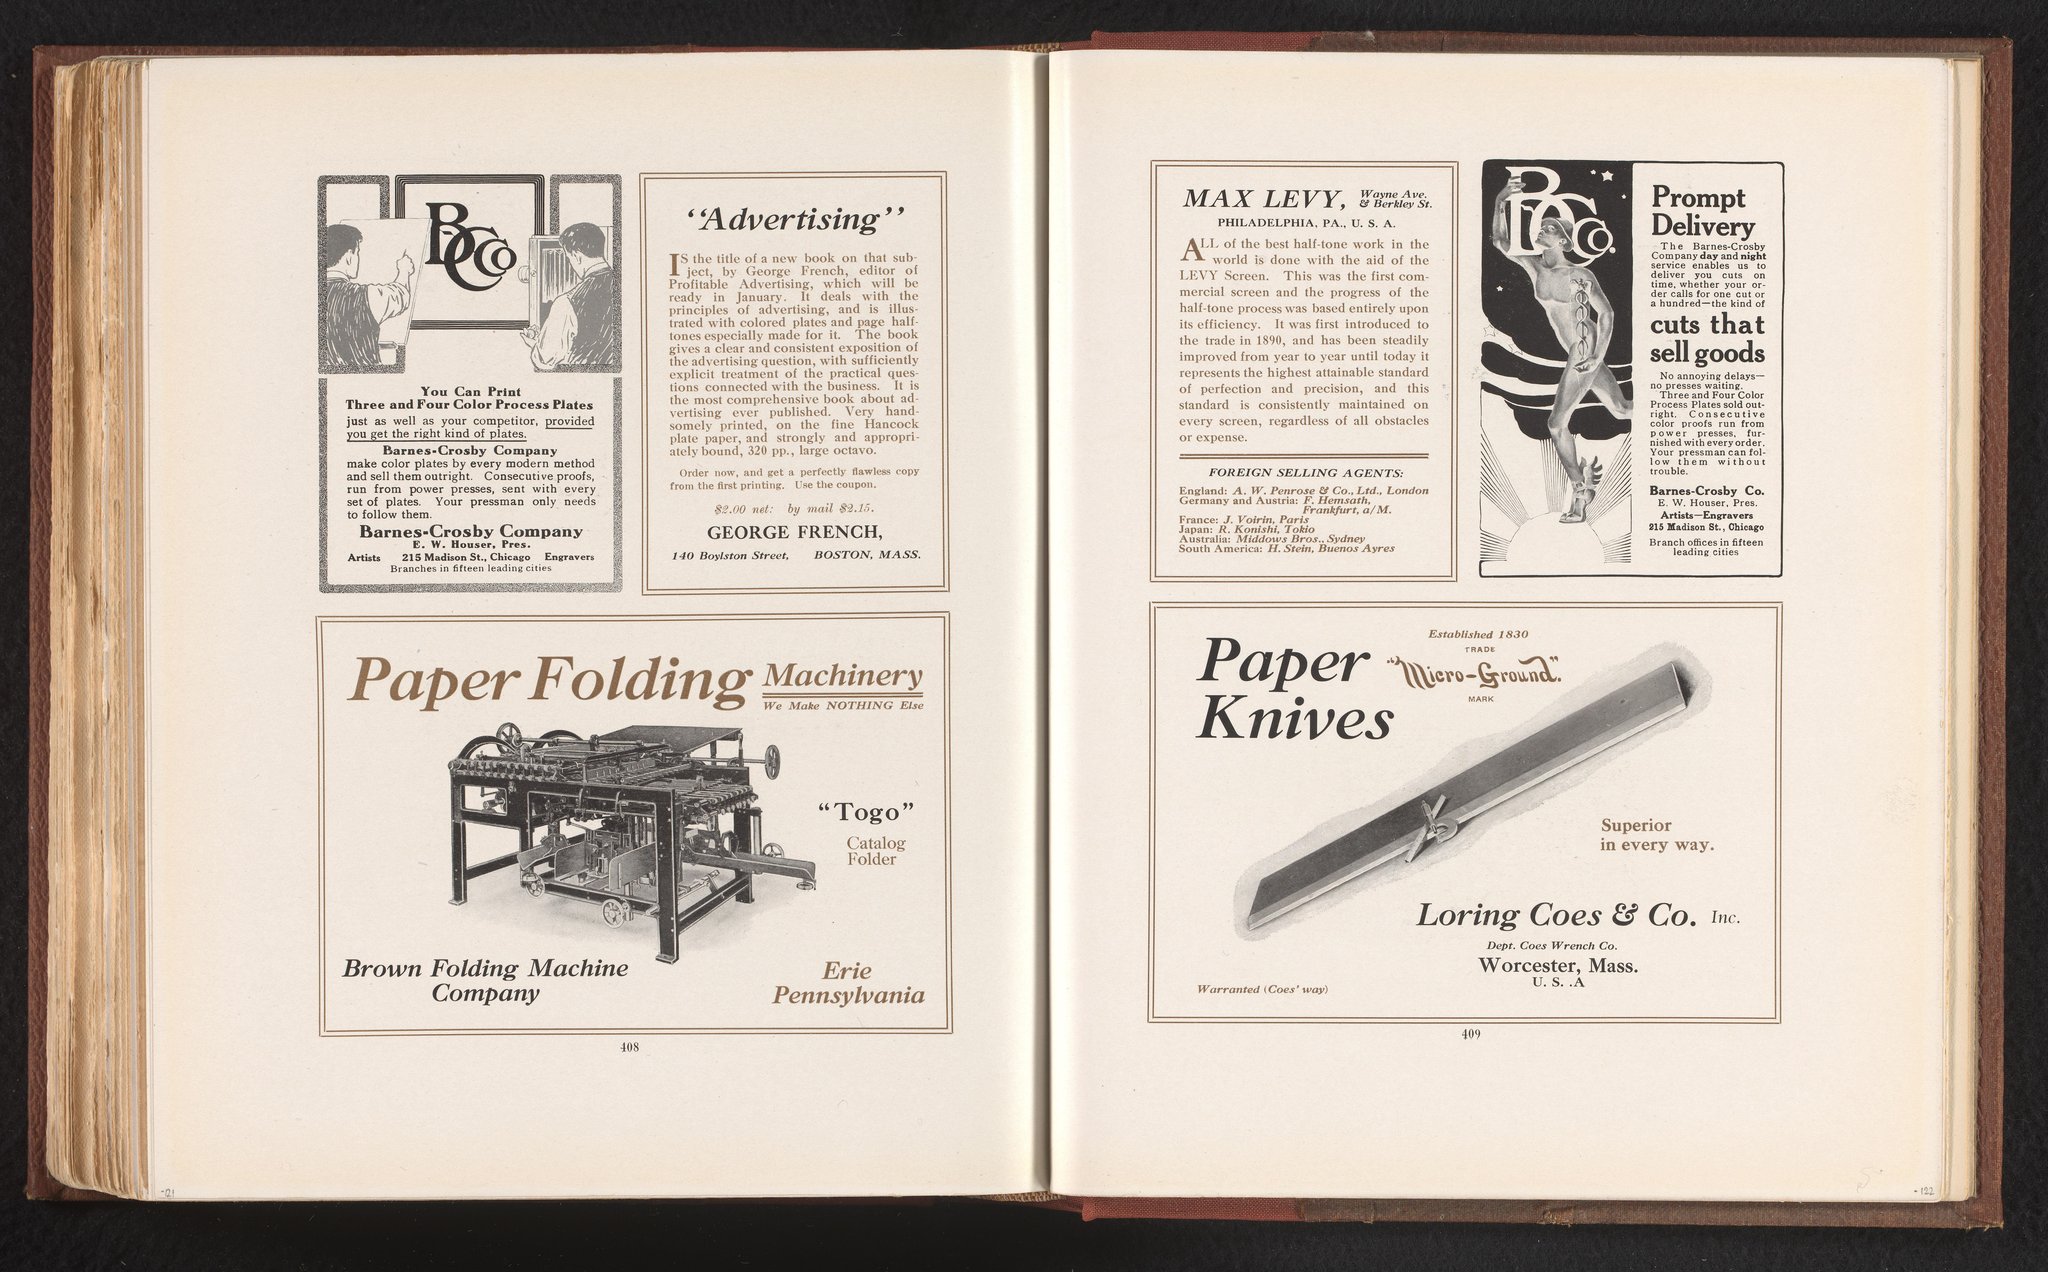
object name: photomechanical print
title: Reclames, waaronder voor de Barnes-Crosby Company geïllustreerd met logo met de Griekse god Hermes en voor Loring Coes & Co. geïllustreerd met hun papiermes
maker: Anonymous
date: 1904-1909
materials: paper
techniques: autotype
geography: worcester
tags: advertising, attributes of mercury, tools, aids, implements ~ crafts and industries: knife